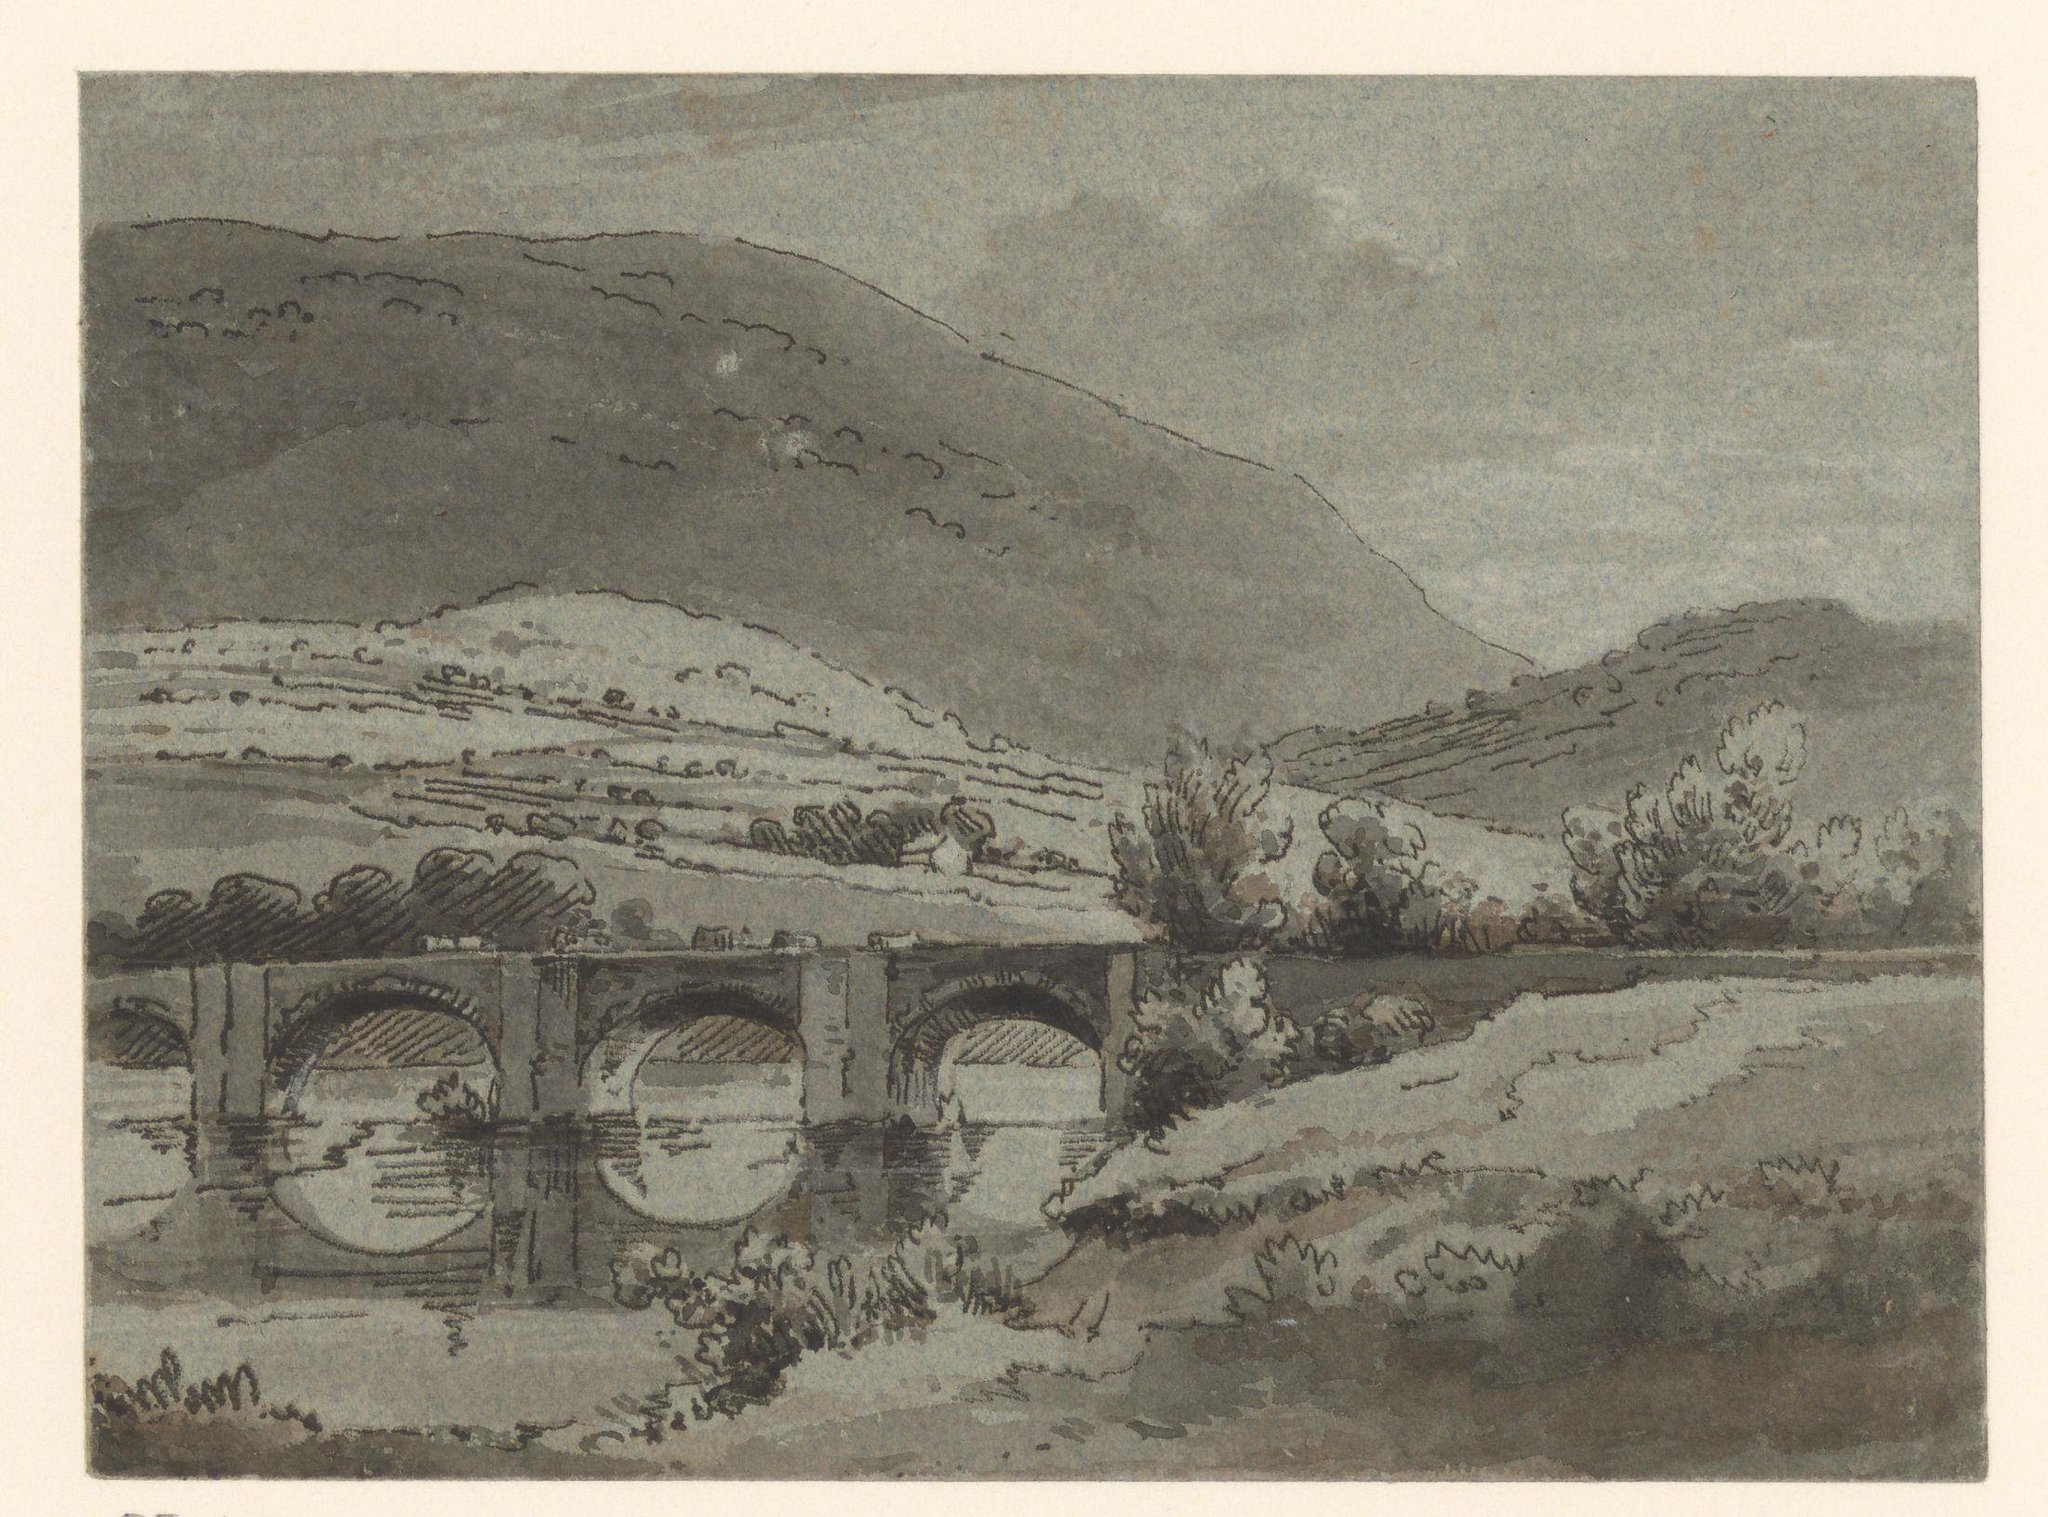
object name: print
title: Heuvelachtig landschap met brug over een rivier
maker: henry edridge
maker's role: draughtsman, painter, print maker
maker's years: 1768-1821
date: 1778-1821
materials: ink, paper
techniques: brush, etching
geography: london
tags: low hill country, river, landscape with bridge, viaduct or aqueduct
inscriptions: collector's mark: Lugt 2760, inscription: ‘[s?]:p:h:’, collector's mark: Lugt 2228